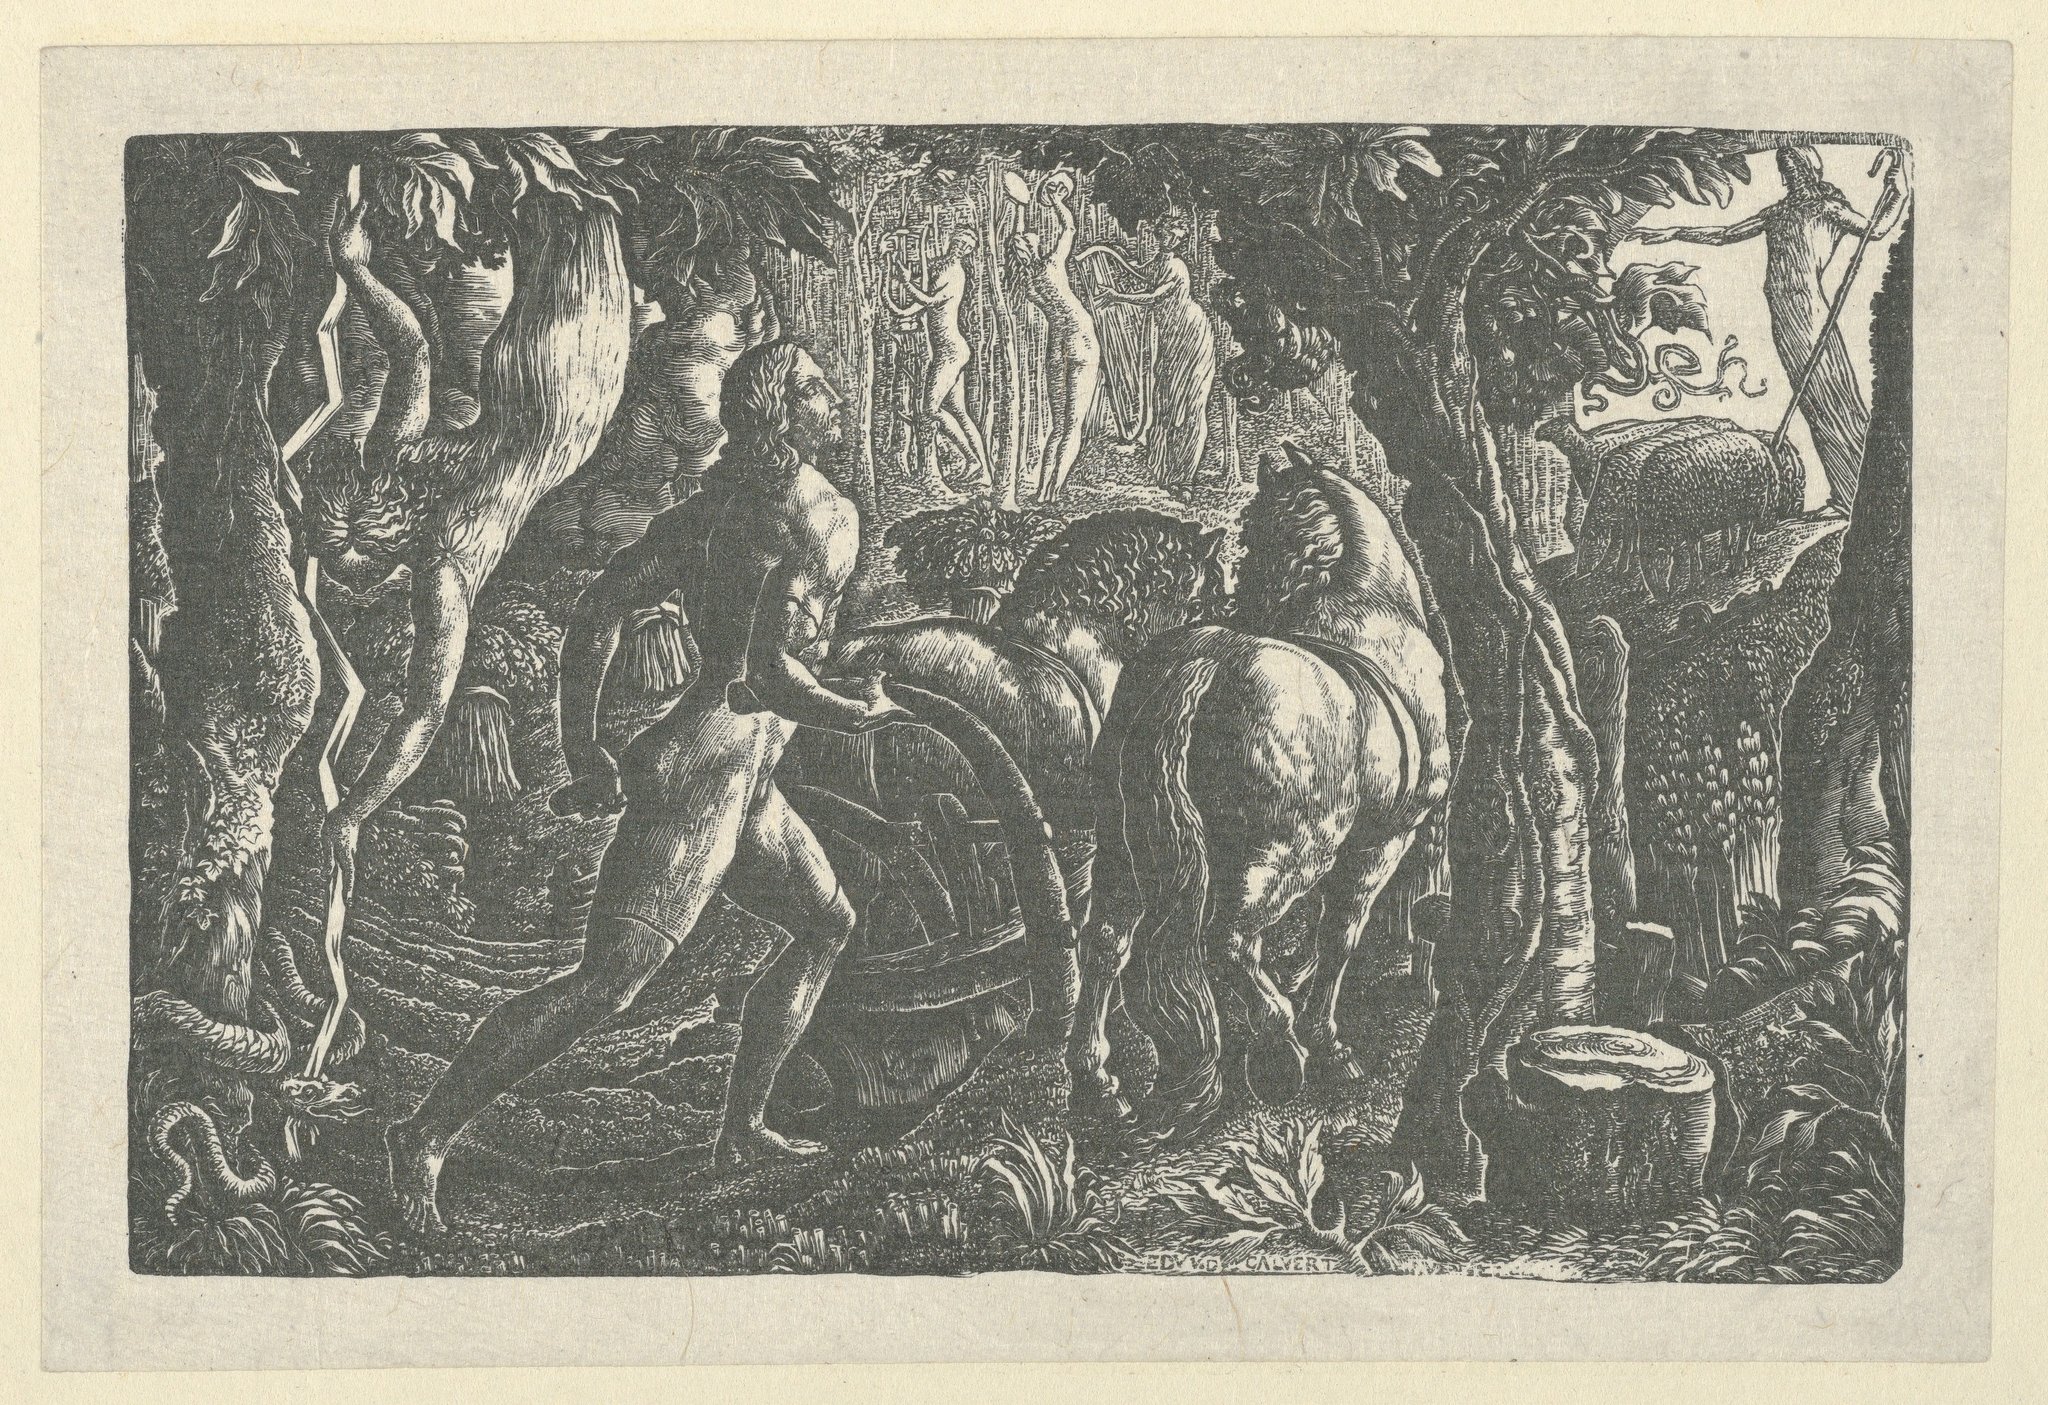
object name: print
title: The Ploughman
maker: edward calvert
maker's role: artist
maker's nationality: british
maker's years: 1799-1883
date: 1827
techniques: engraving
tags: male nudes,horses,snakes,trees